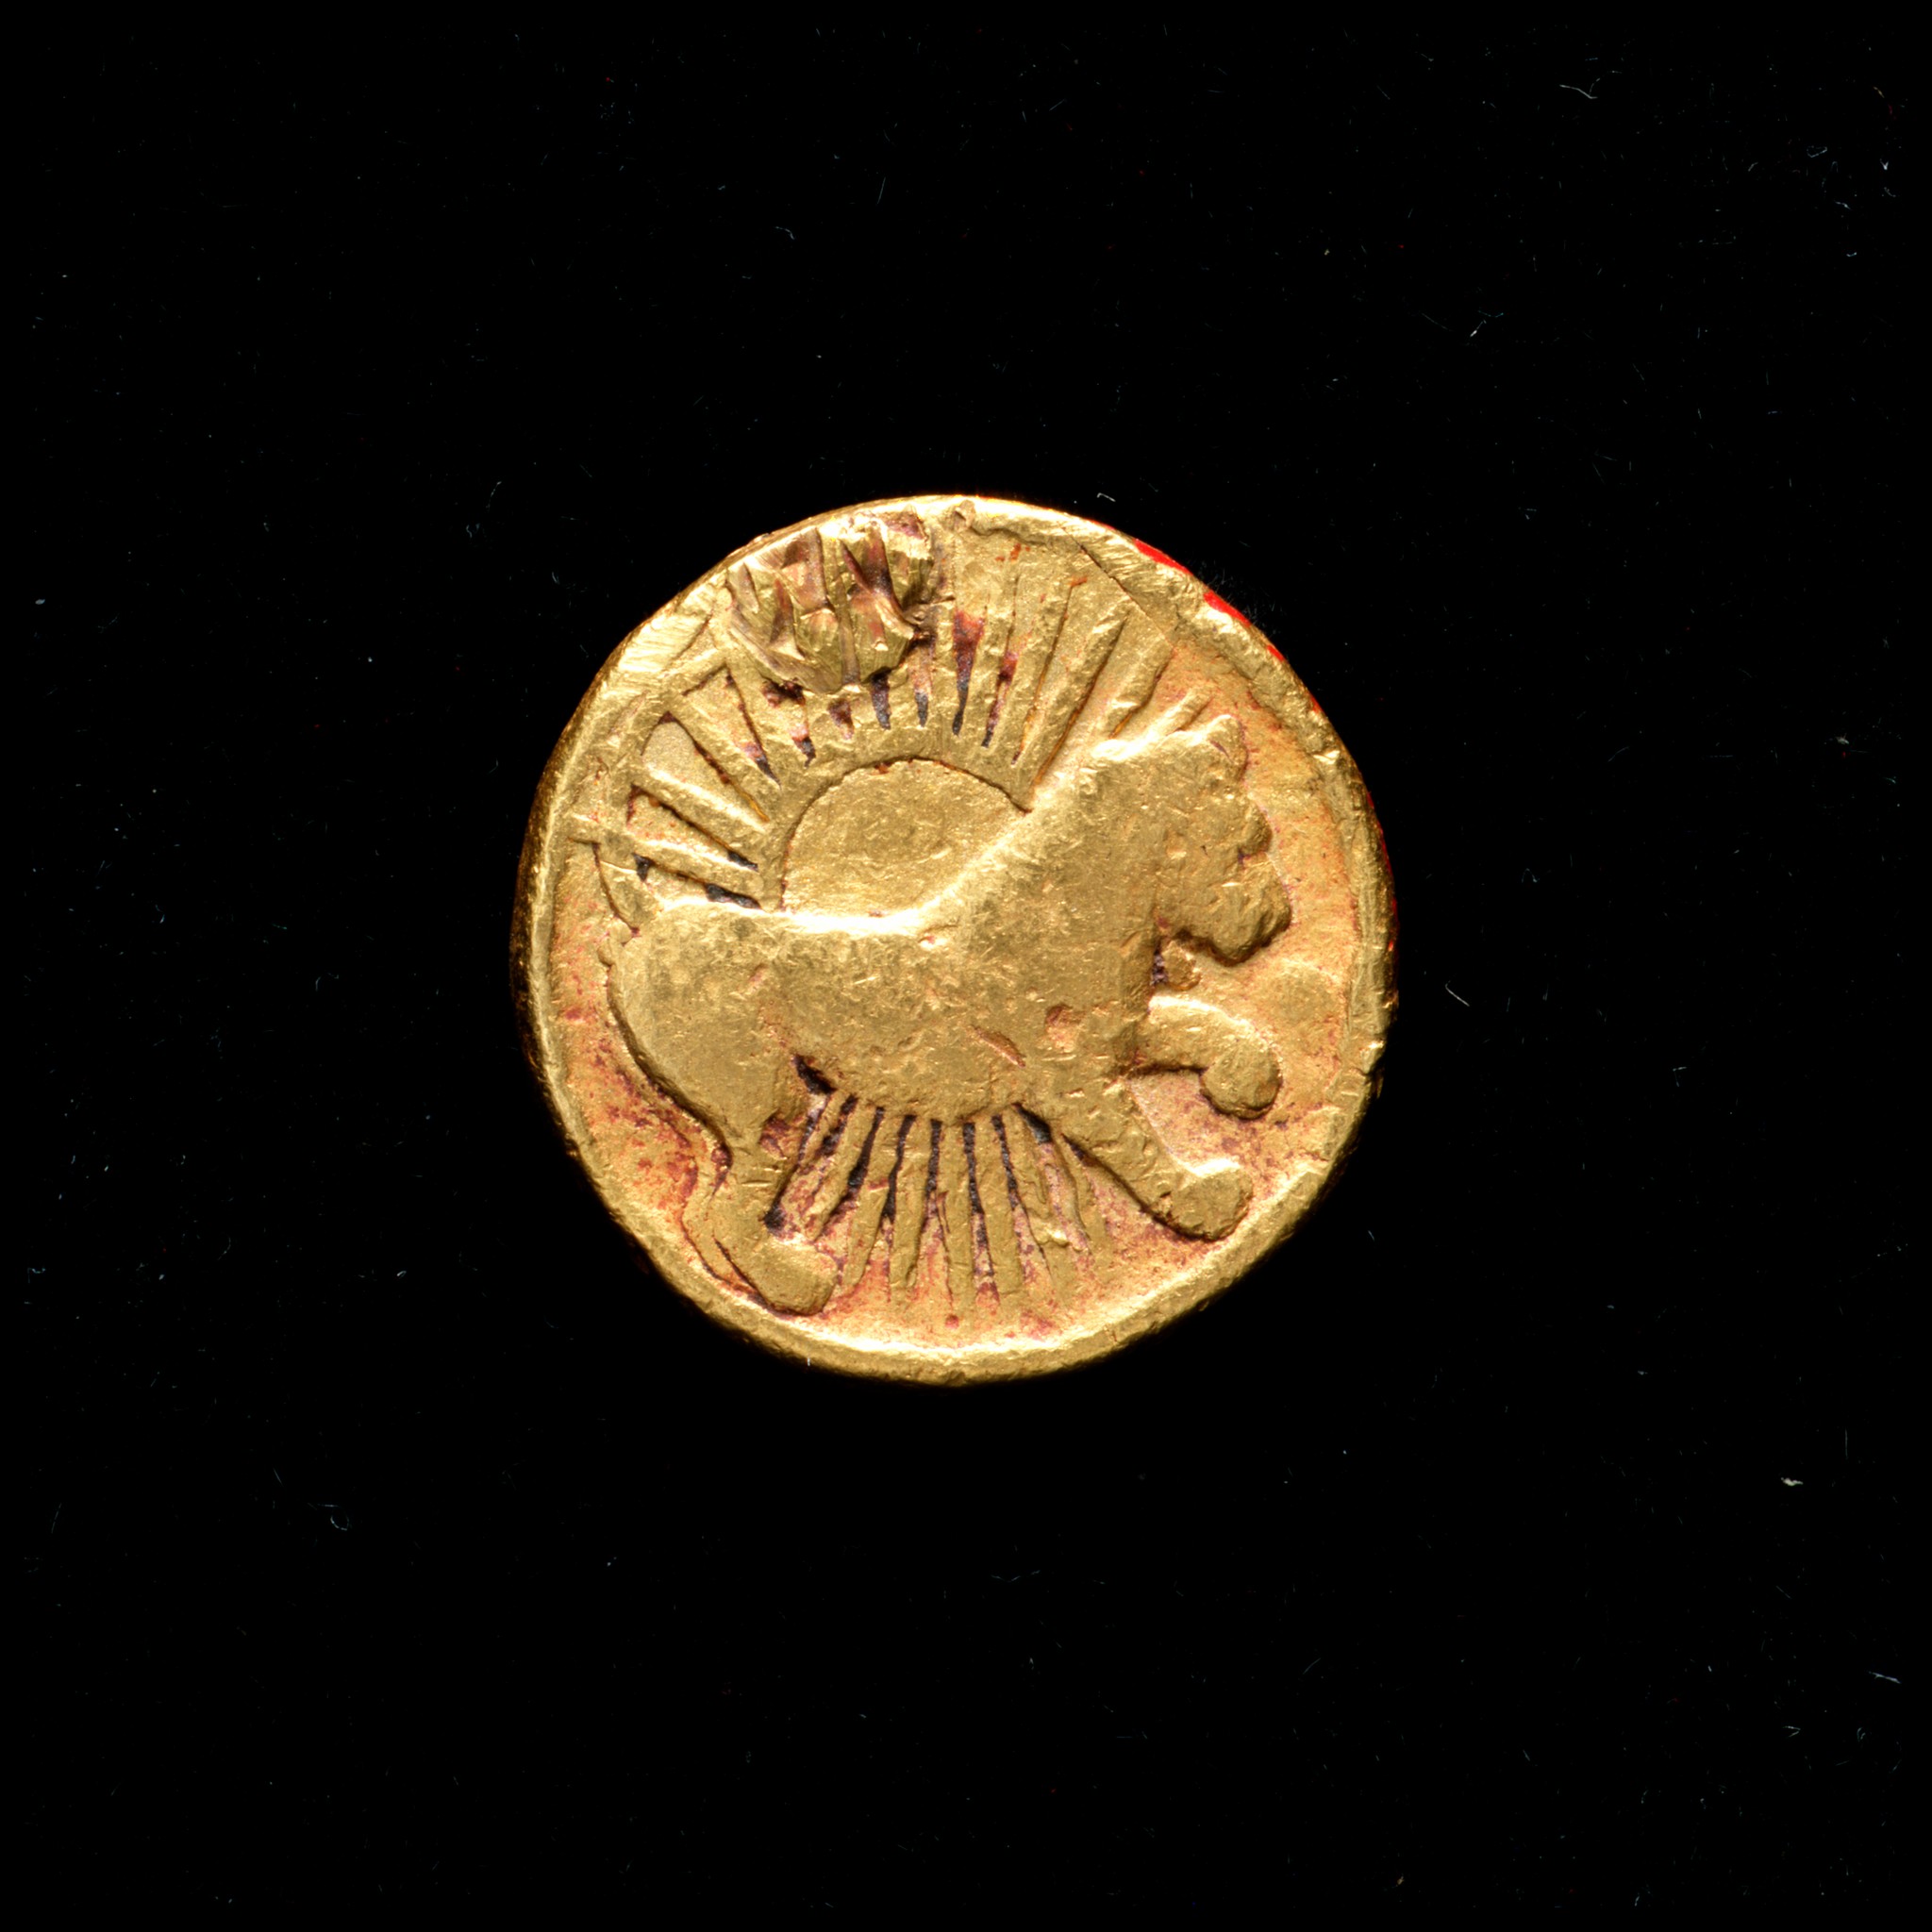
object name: coin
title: Coin with Sign of Leo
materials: gold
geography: india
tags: lions,zodiac